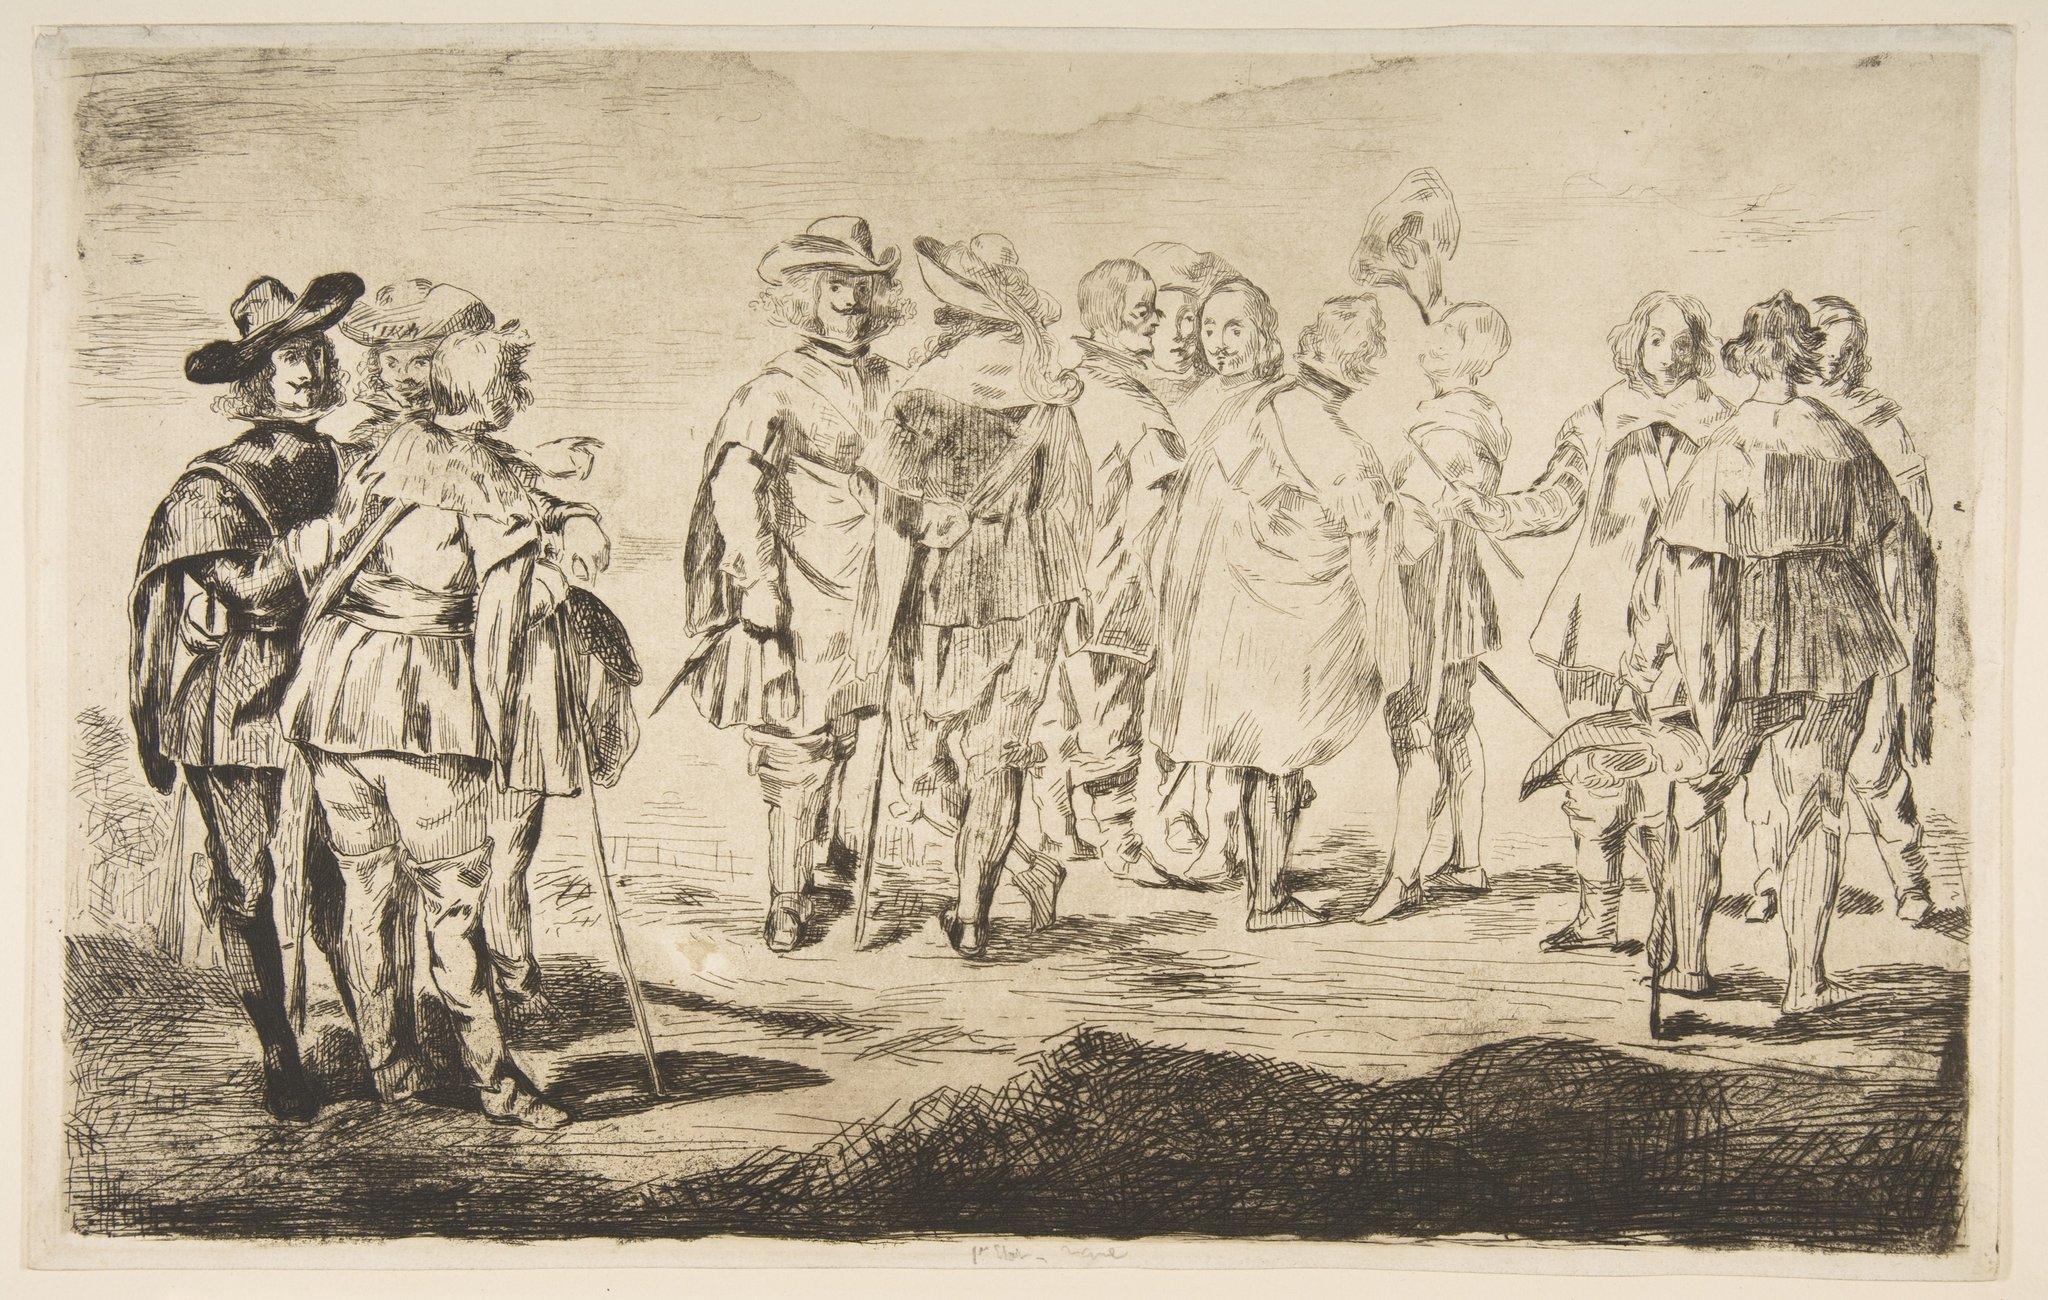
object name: print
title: The Little Cavaliers, after "Velázquez"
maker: édouard manet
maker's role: artist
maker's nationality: french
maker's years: 1832-1883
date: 1861-1862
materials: paper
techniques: drypoint, etching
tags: men